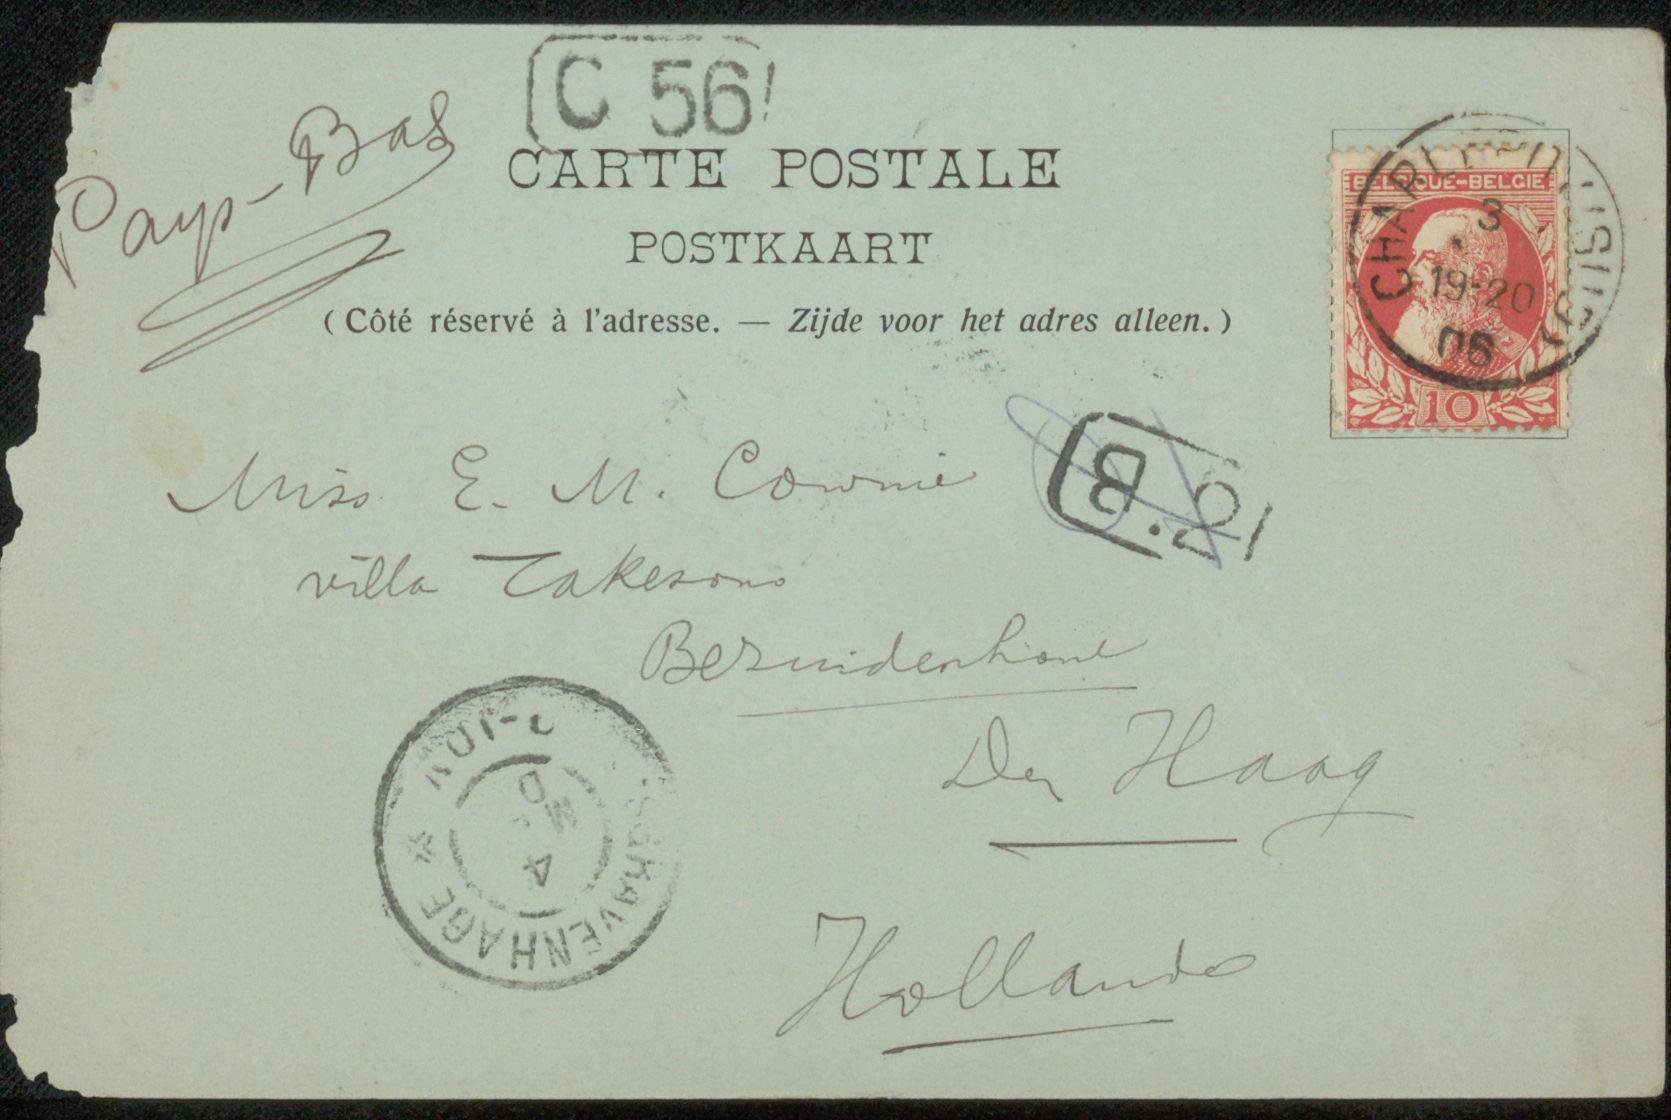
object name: postcard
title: Briefkaart aan Elsie Maud Cownie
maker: philip zilcken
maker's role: draughtsman, painter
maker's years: 1857-1930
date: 1906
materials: cardboard, ink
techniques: pen, writing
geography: charleroi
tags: manchester, the hague, draughtsman, elsie maud cownie